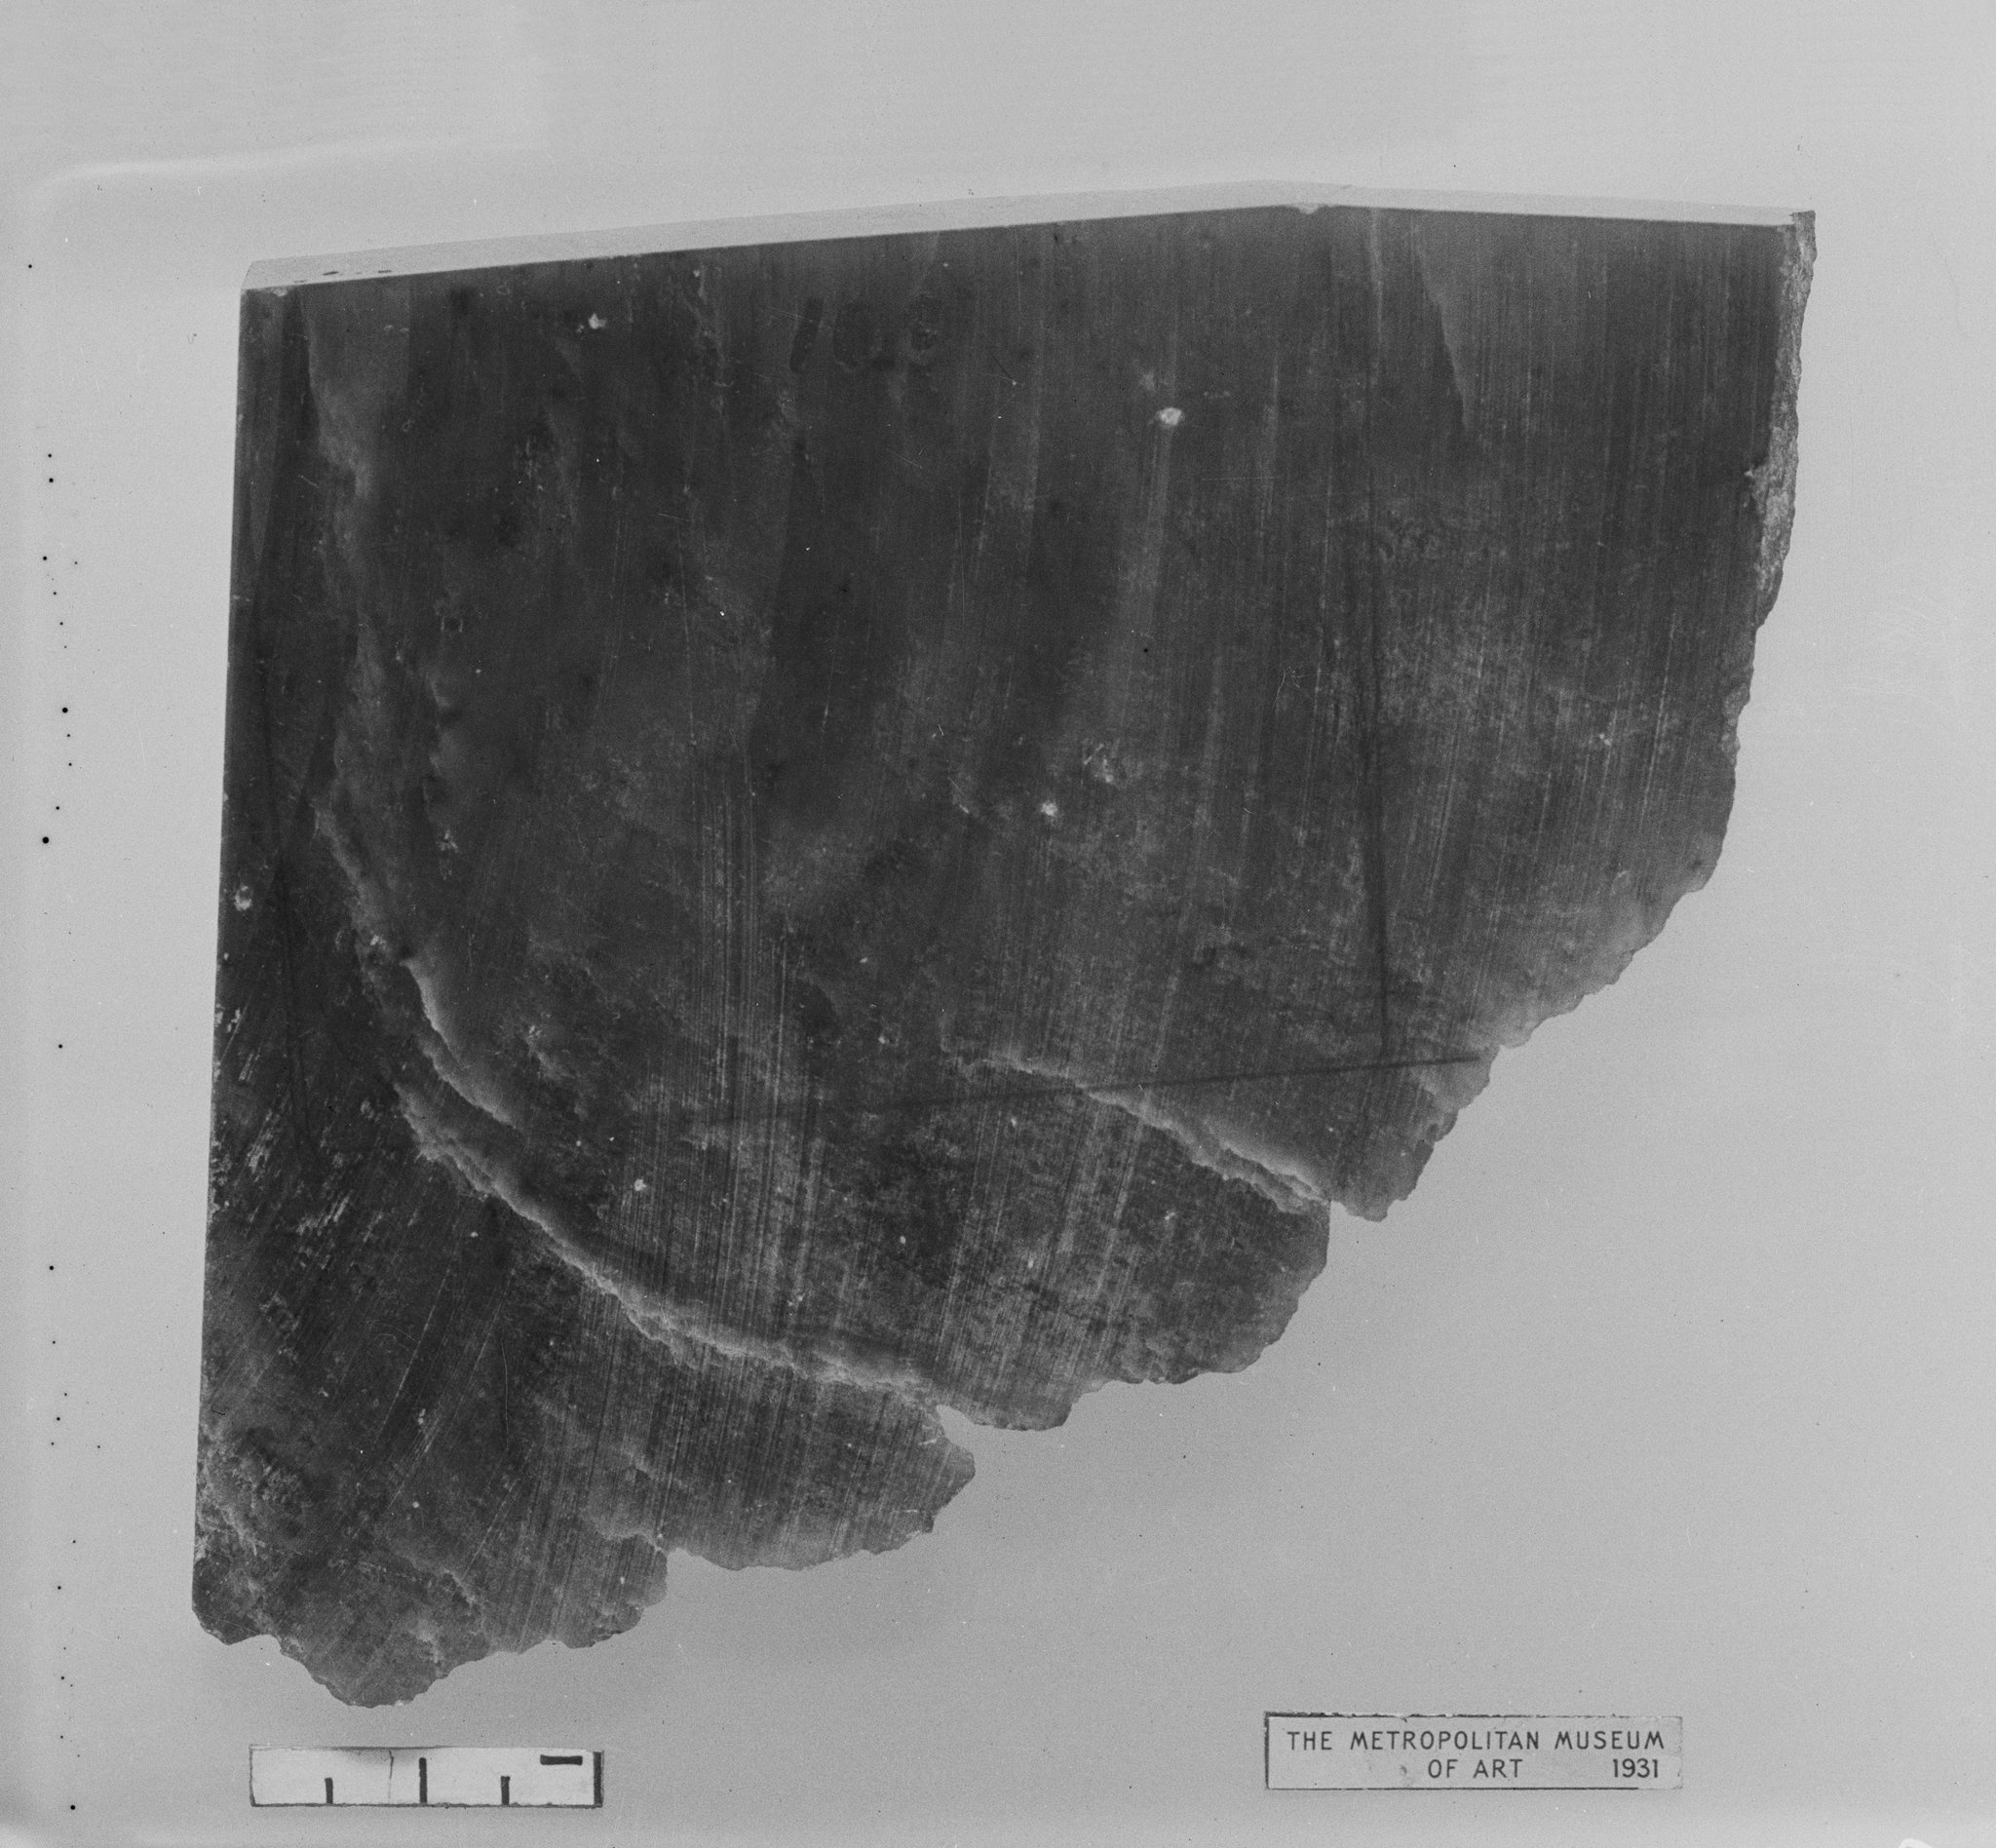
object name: fragment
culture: russian, siberia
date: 1902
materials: jade